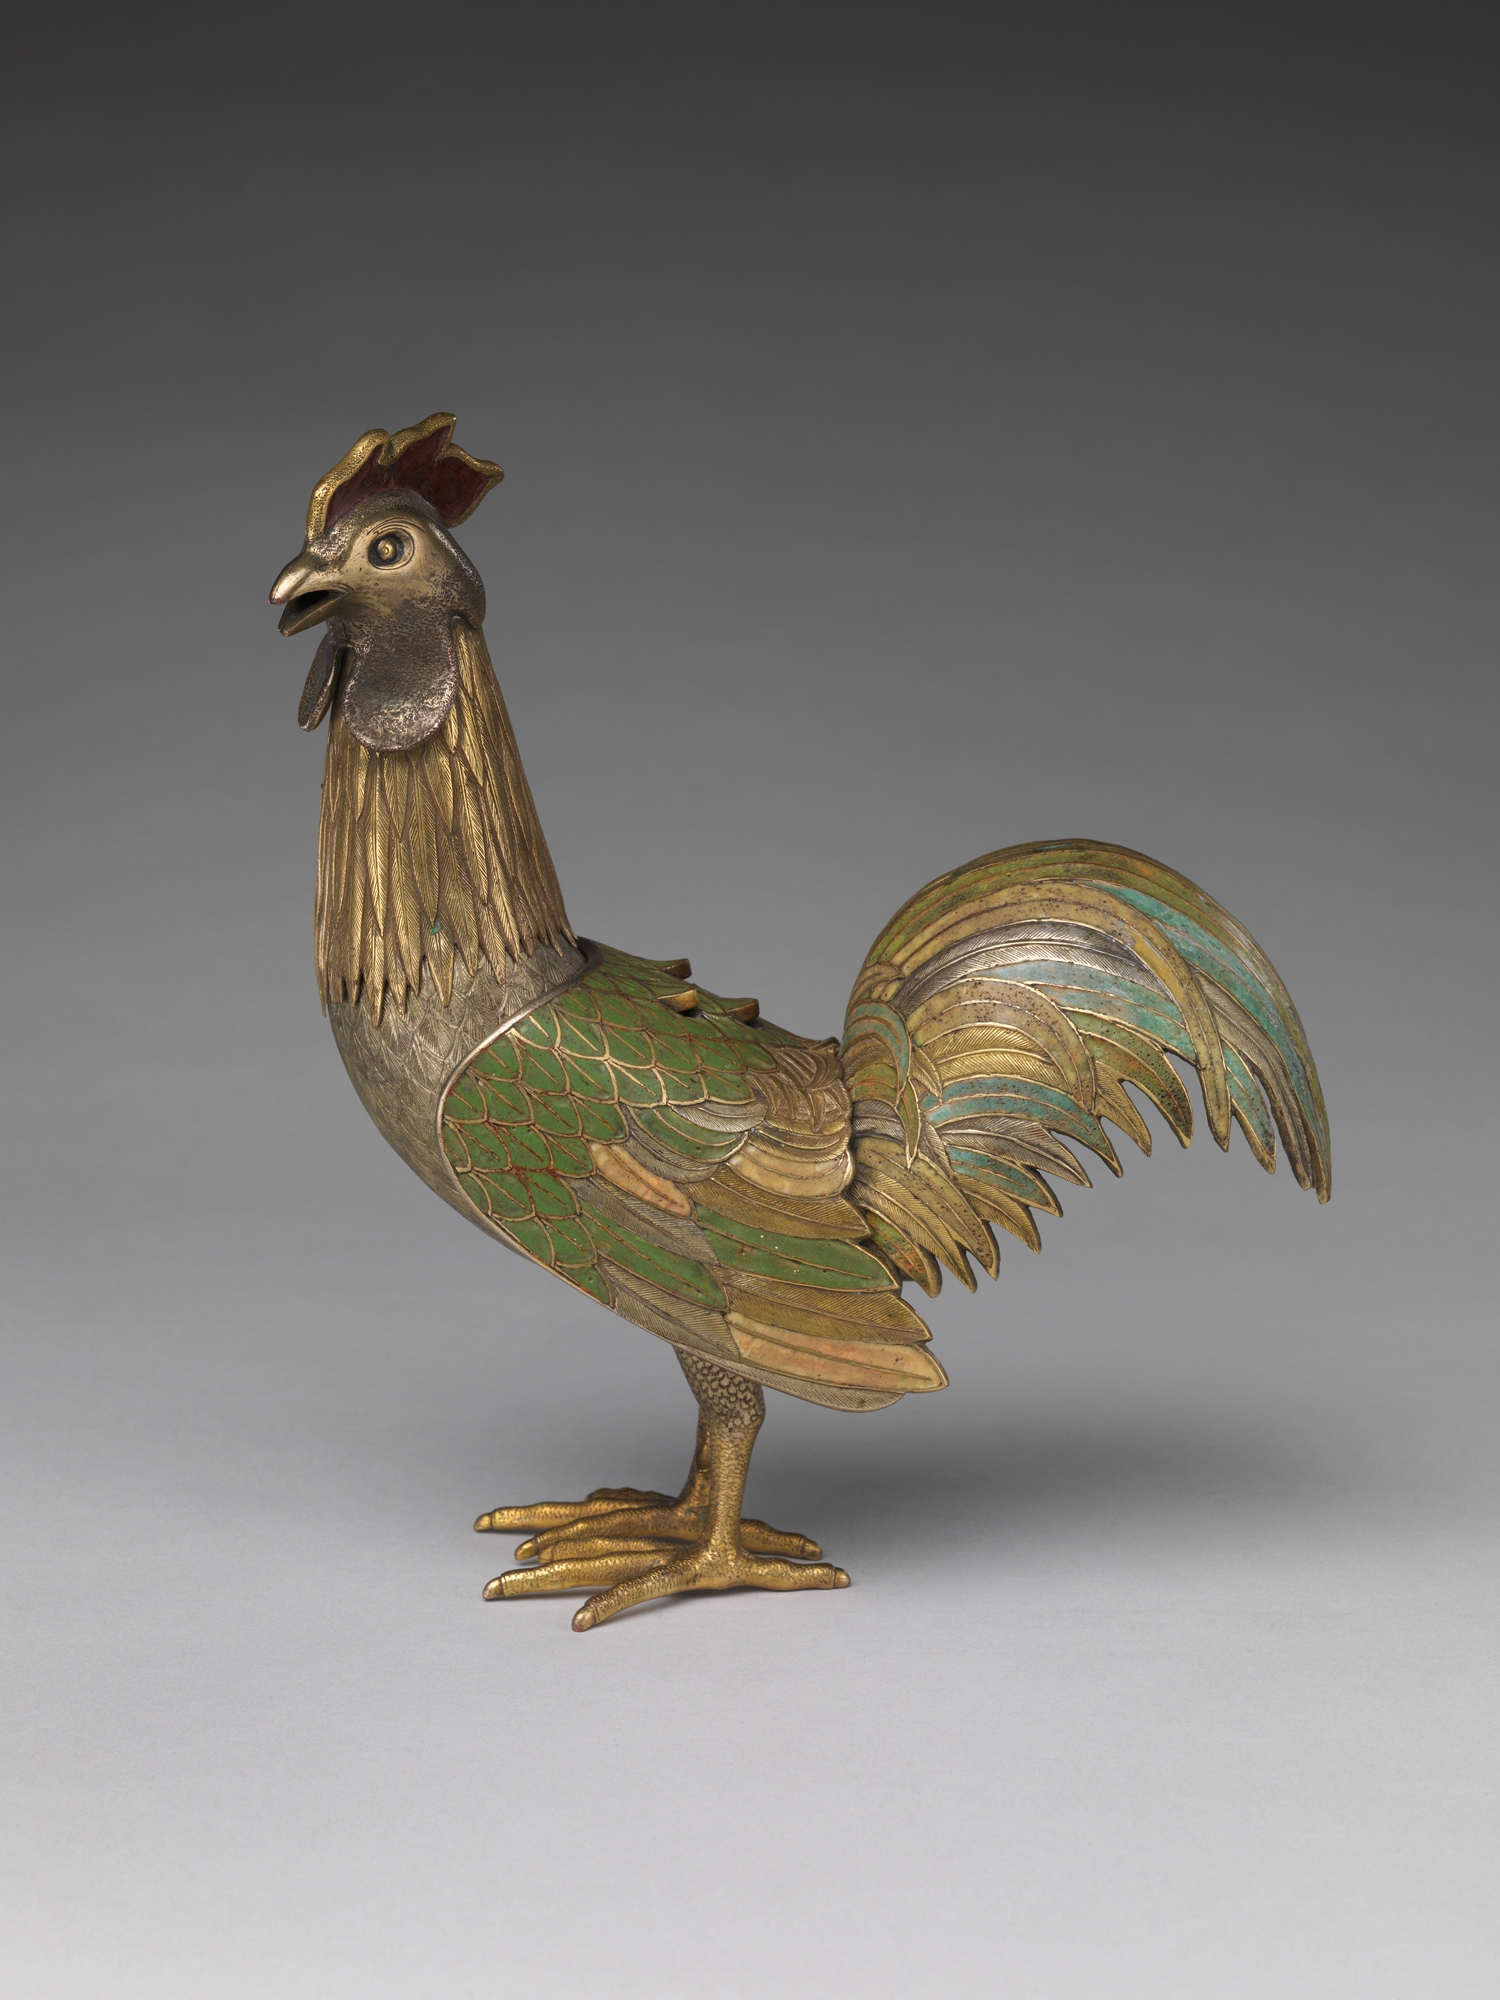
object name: incense burner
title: Incense Burner in the Shape of a Rooster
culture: japanese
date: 1701-1800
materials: copper alloy, enamel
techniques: gilding, silvering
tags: roosters